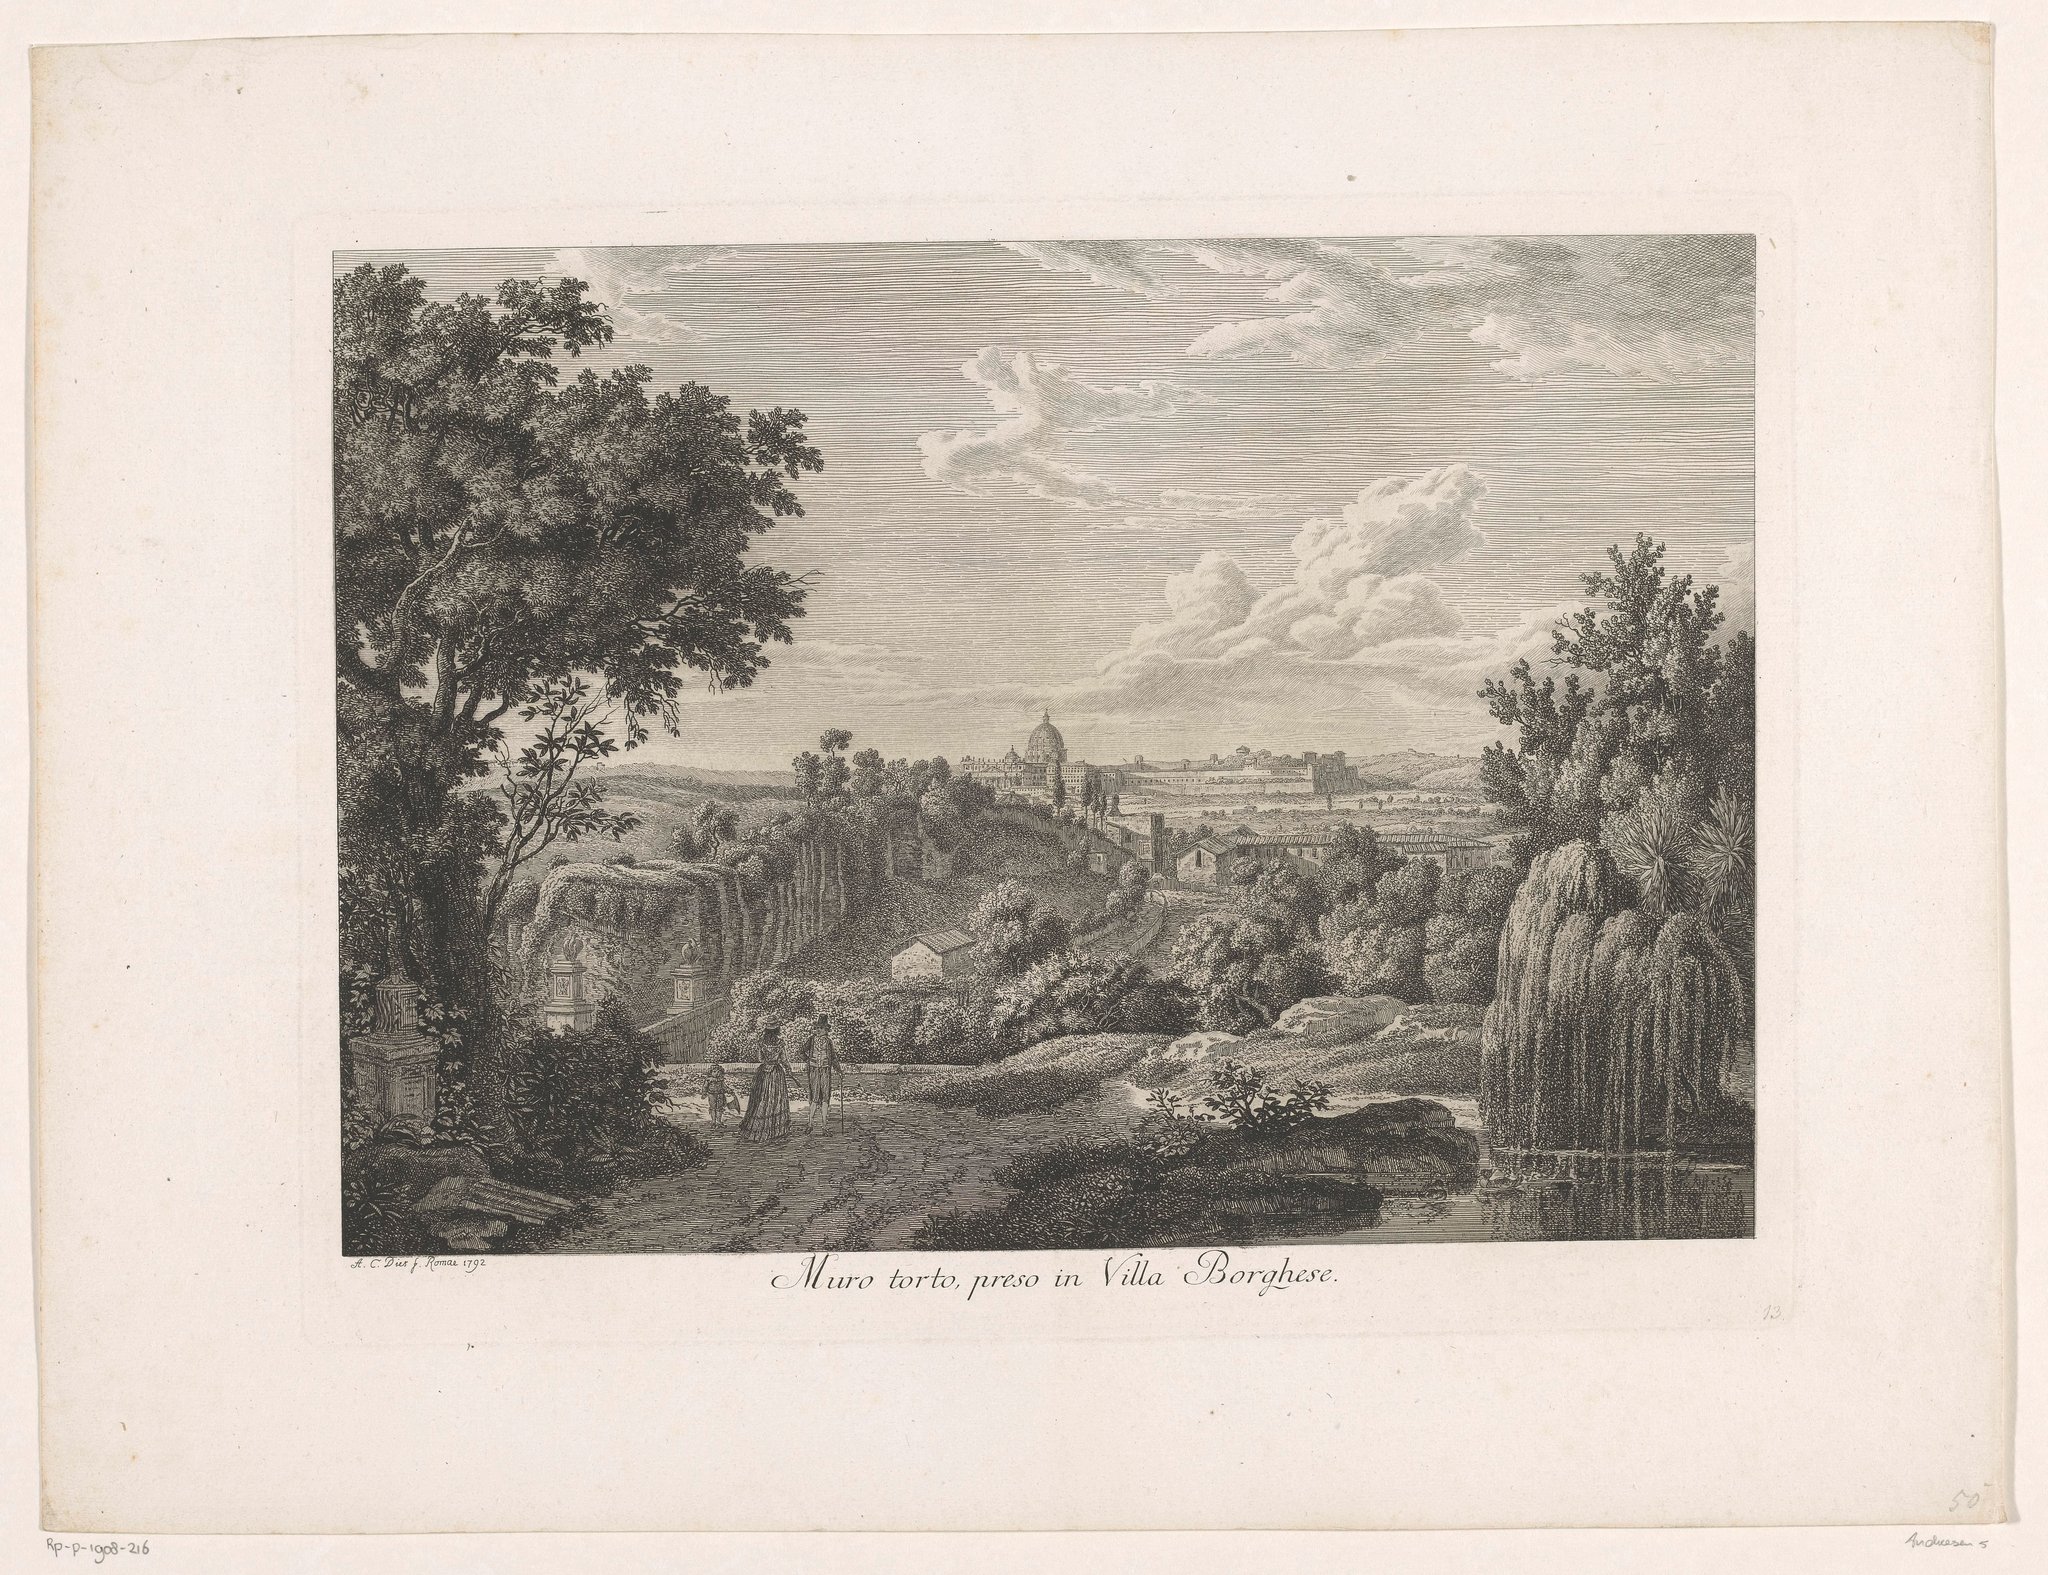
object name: print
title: Begroeide muur bij Villa Borghese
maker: albert christoph dies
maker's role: painter, print maker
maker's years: 1755-1822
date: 1792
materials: paper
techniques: etching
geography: rome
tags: city-view, and landscape with man-made constructions (+ city(-scape) with figures, staffage), village-walls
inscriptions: collector's mark: Lugt 2228